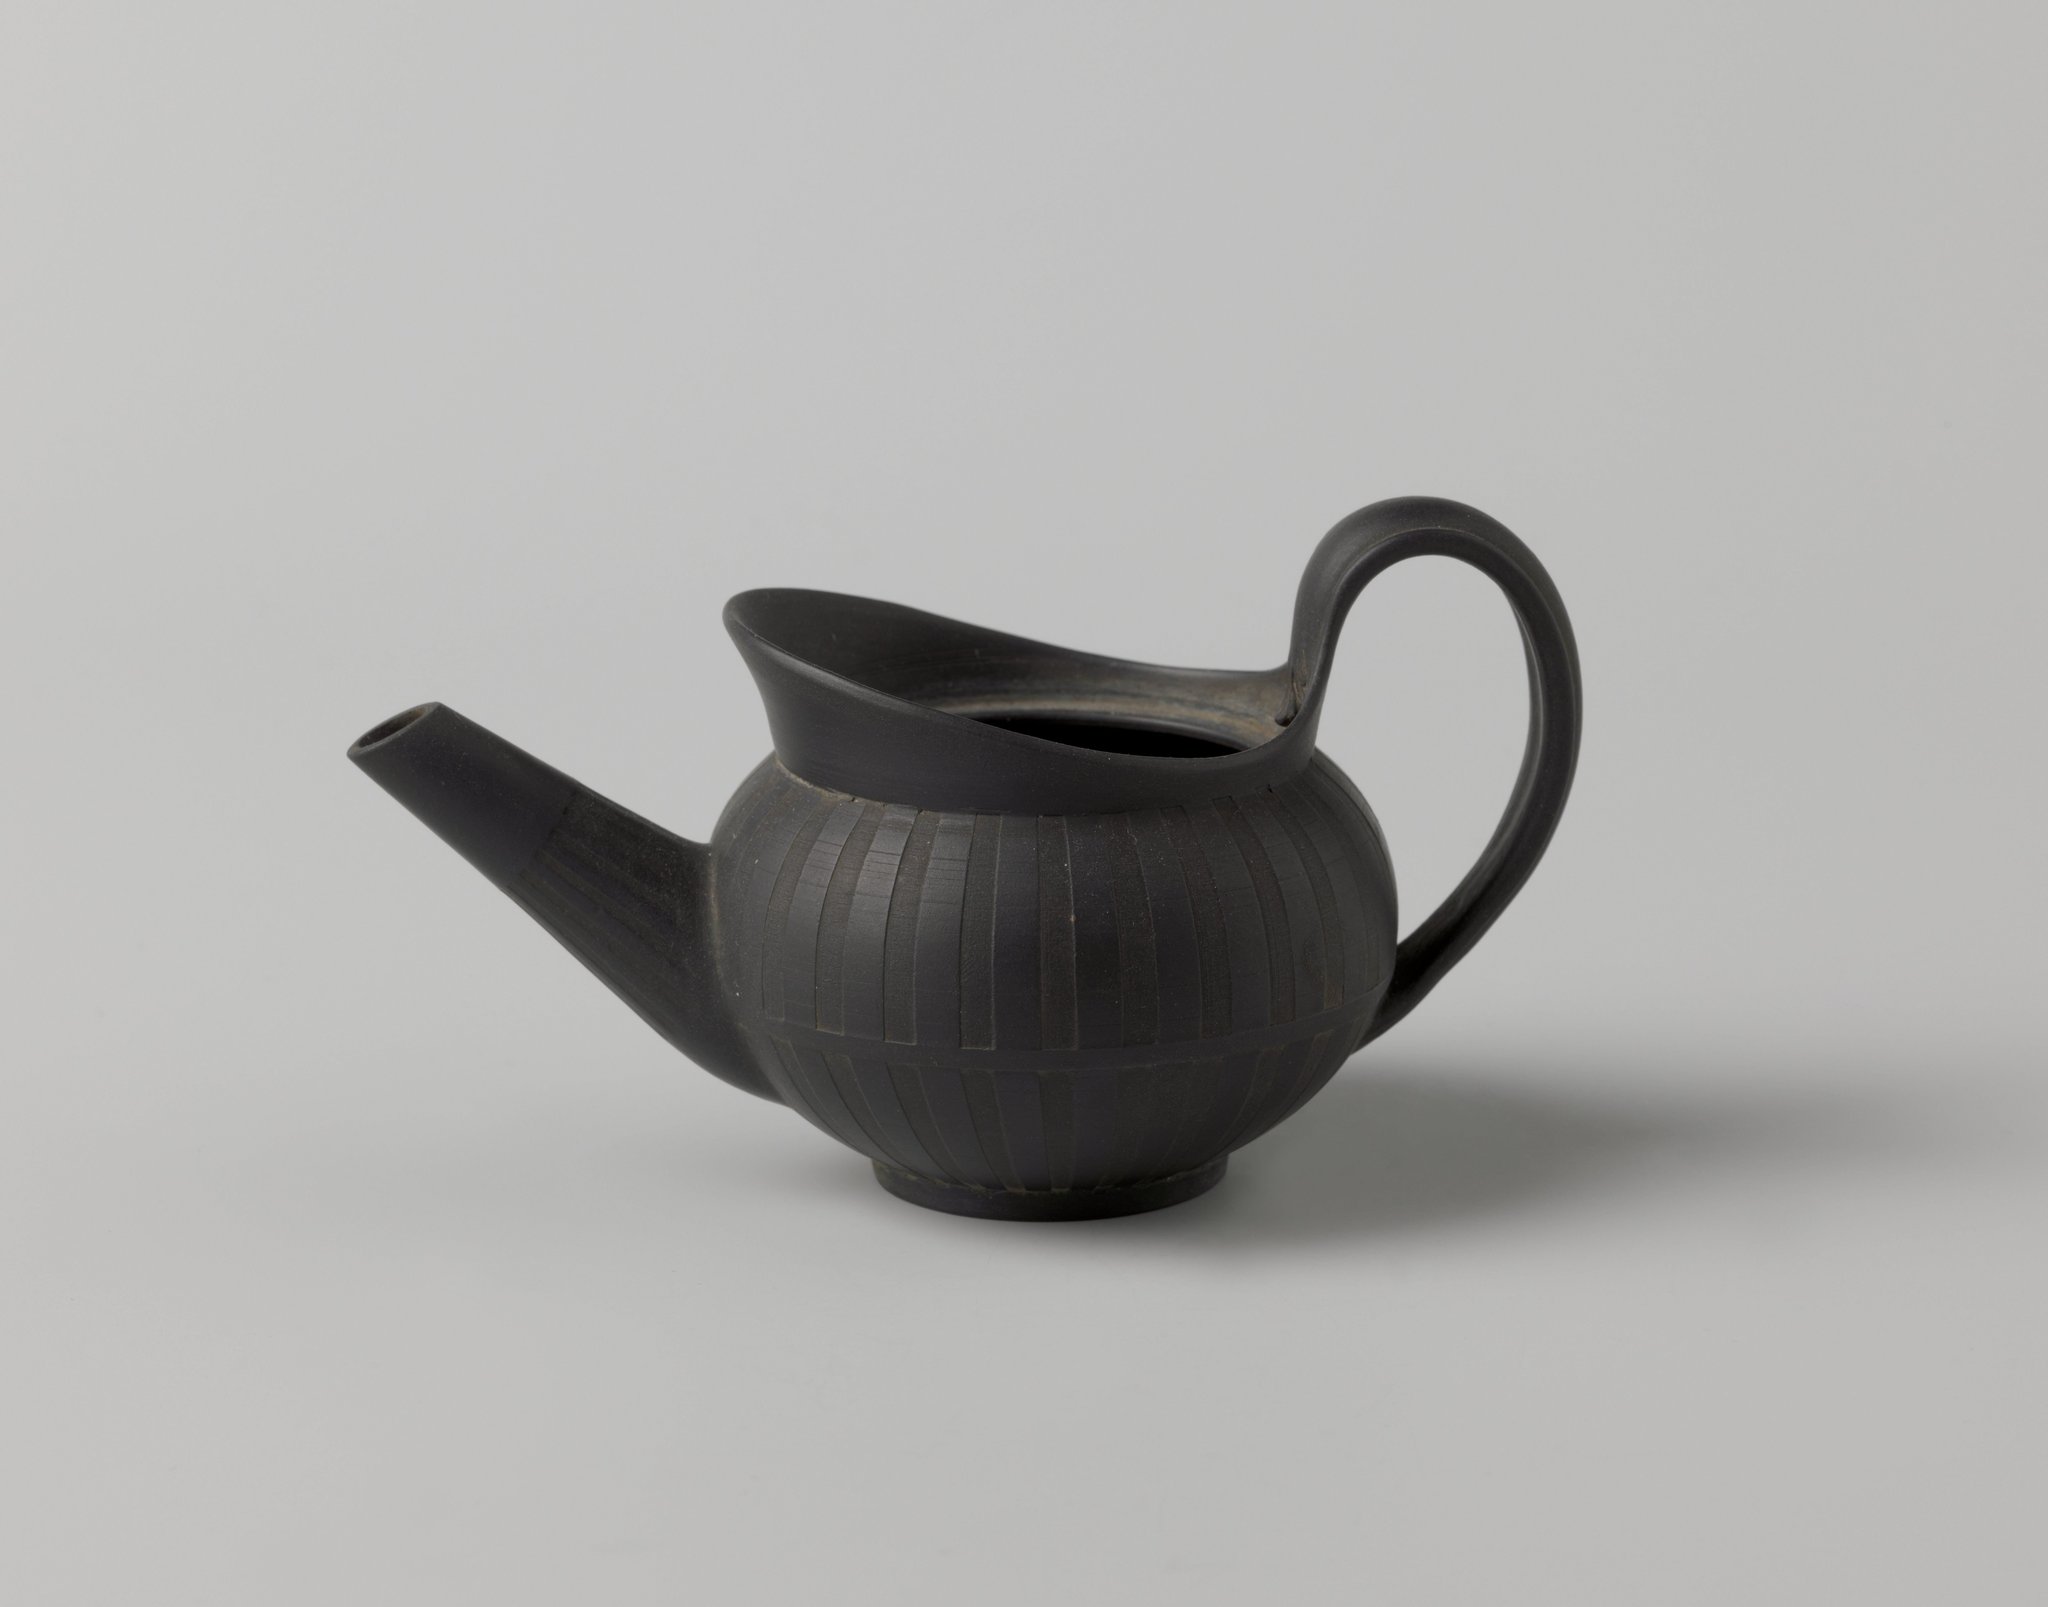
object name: pot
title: Theepot van aardewerk, Wedgwood Black Basalt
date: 1790-1810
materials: earthenware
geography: england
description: Bolvormige theepot, zonder deksel, van aardewerk, BLack Basalt. De pot heeft een C-cormig oor, een rechte tuit en een opstaande rand. De rand is aan de kant van de tuit hoger dan aan de kant van het oor. Het oor eindigt bij de rand in een bladvorm. Het deksel ontbreekt. De buik van de pot is door horizontale banden in twee helften verdeeld. De twee helften en de tuit zijn versierd met cannelures. De pot is gemerkt.